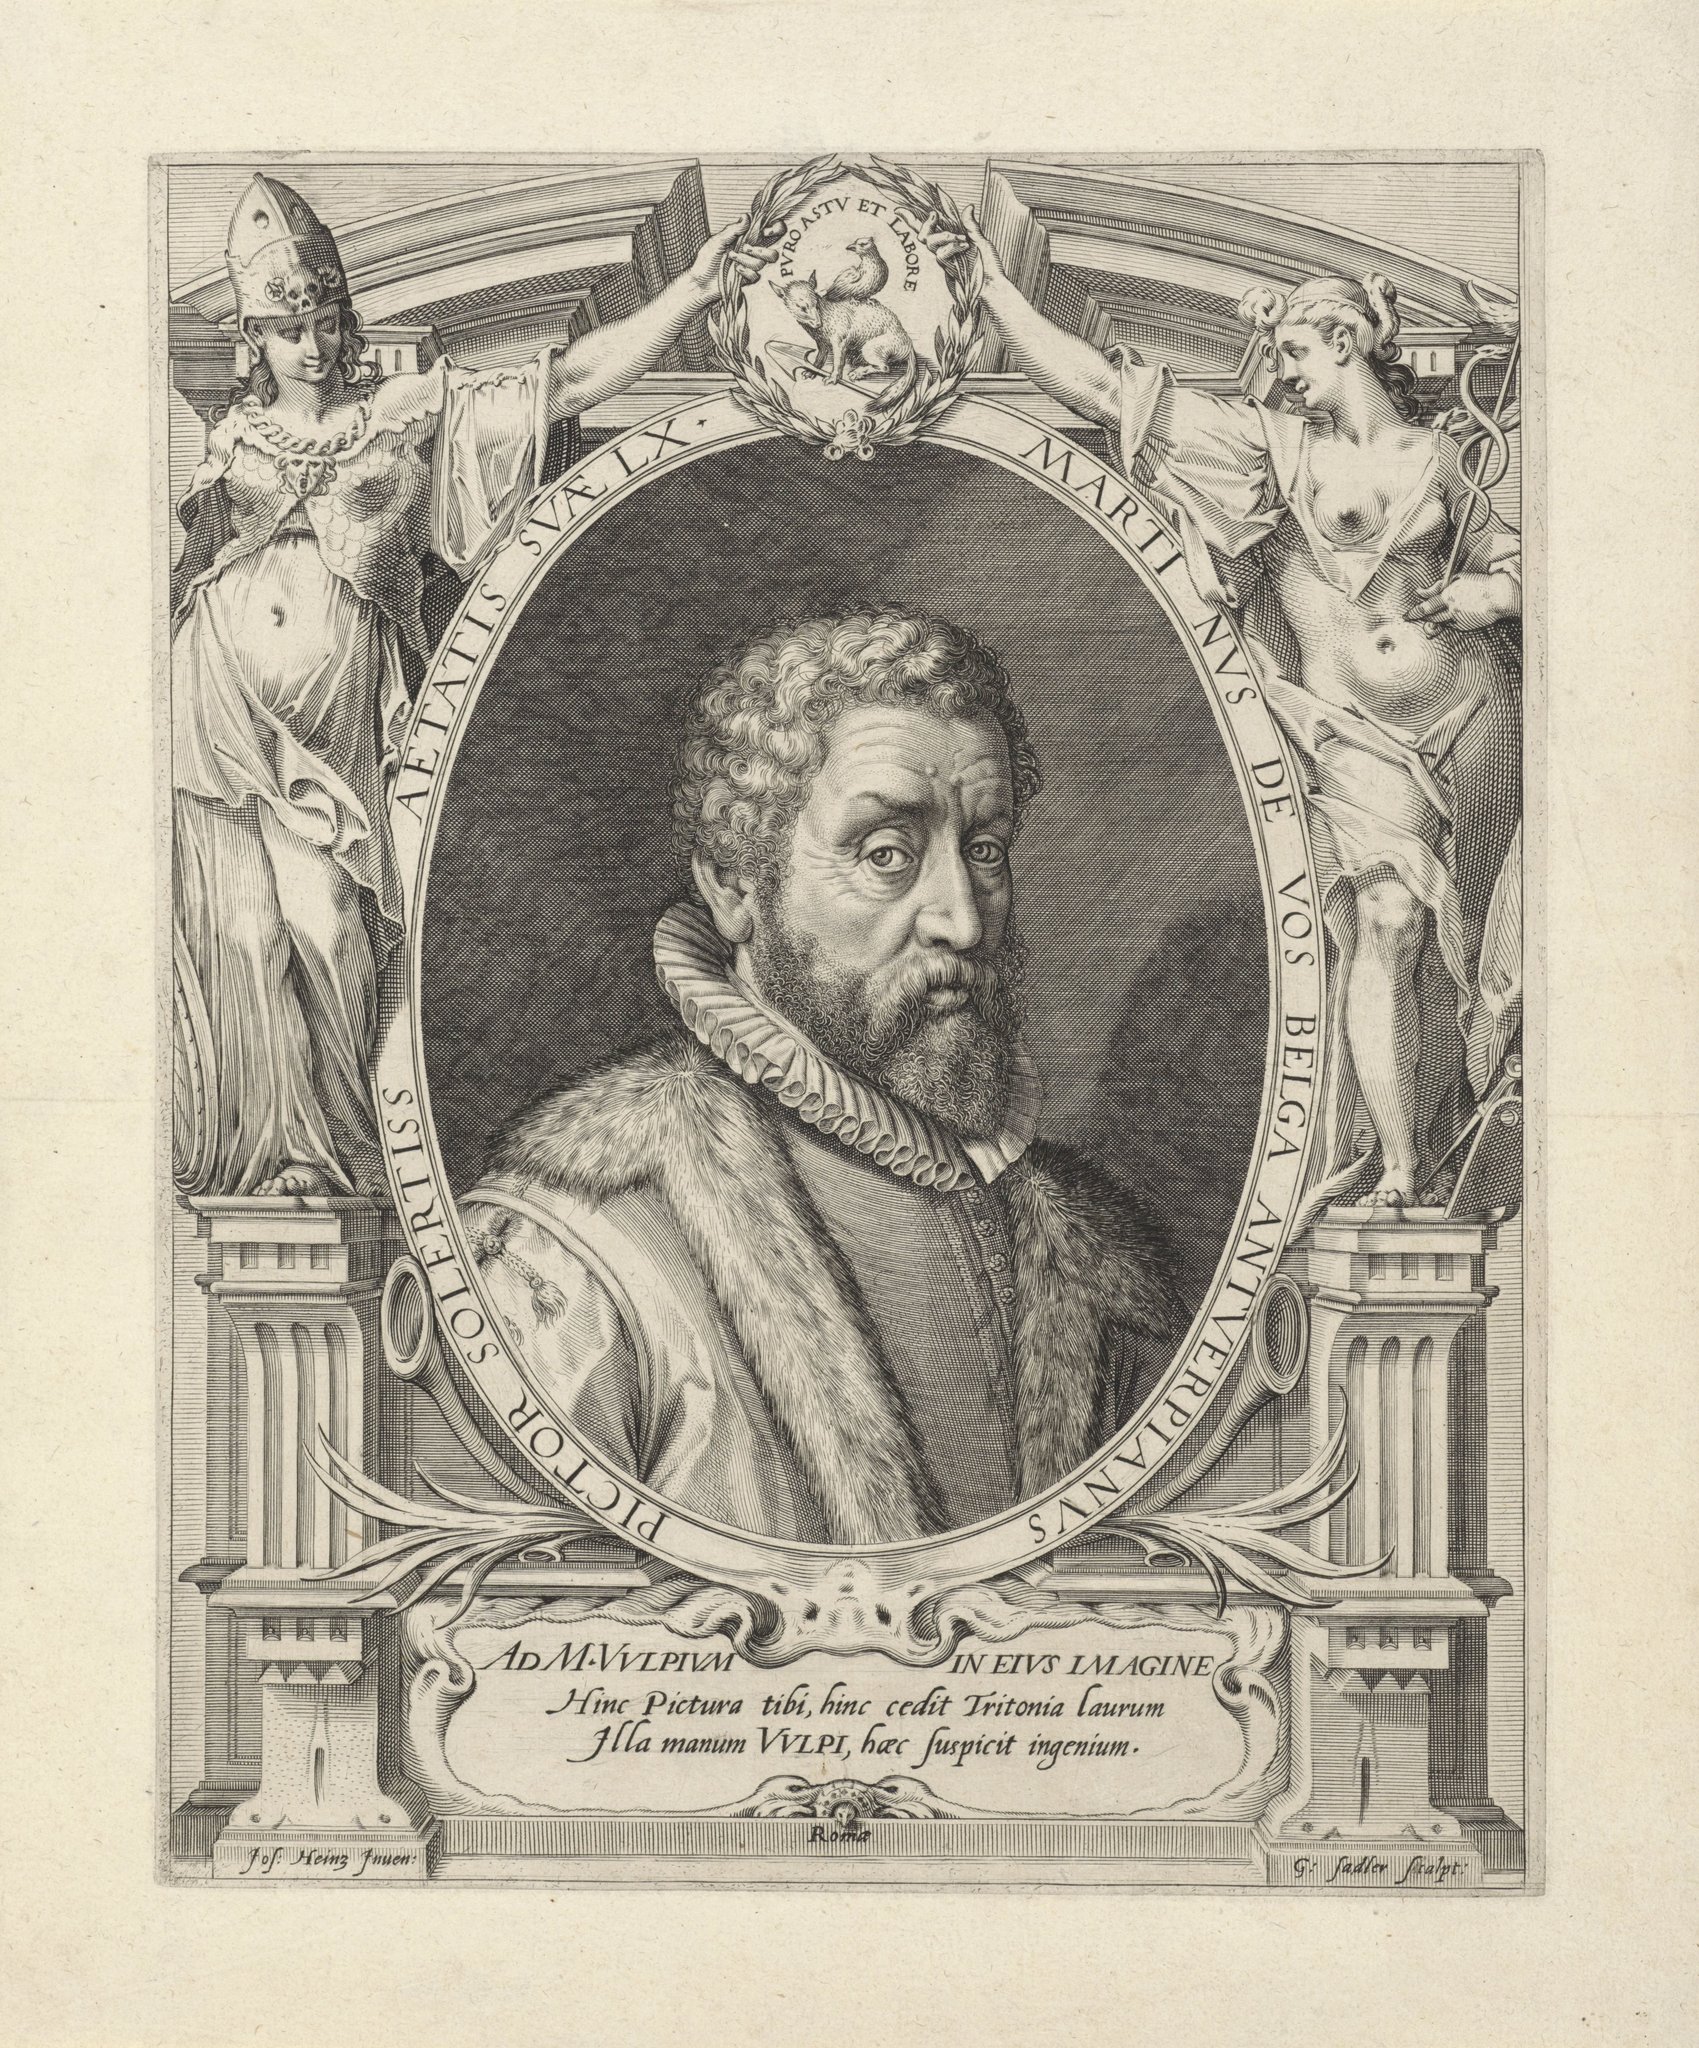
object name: print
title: Portret van Maerten de Vos op 60-jarige leeftijd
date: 1592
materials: paper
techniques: engraving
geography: rome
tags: antwerp, painter, draughtsman, maerten de vos, neck-gear ~ clothing (with name) (+ men's clothes), coat (+ fur used for clothes), coat (+ men's clothes), portrait, self-portrait of painter, beasts of prey, predatory animals: fox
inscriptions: collector's mark: Lugt 2233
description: Portret van de Antwerpse schilder en tekenaar Maerten de Vos, op 60-jarige leeftijd. Twee allegorische vrouwenfiguren (Retorica (r.) en Minerva (l)) houden een lauwerkrans boven het portret. In de lauwerkrans een embleem van een vogel die op een vos zit.